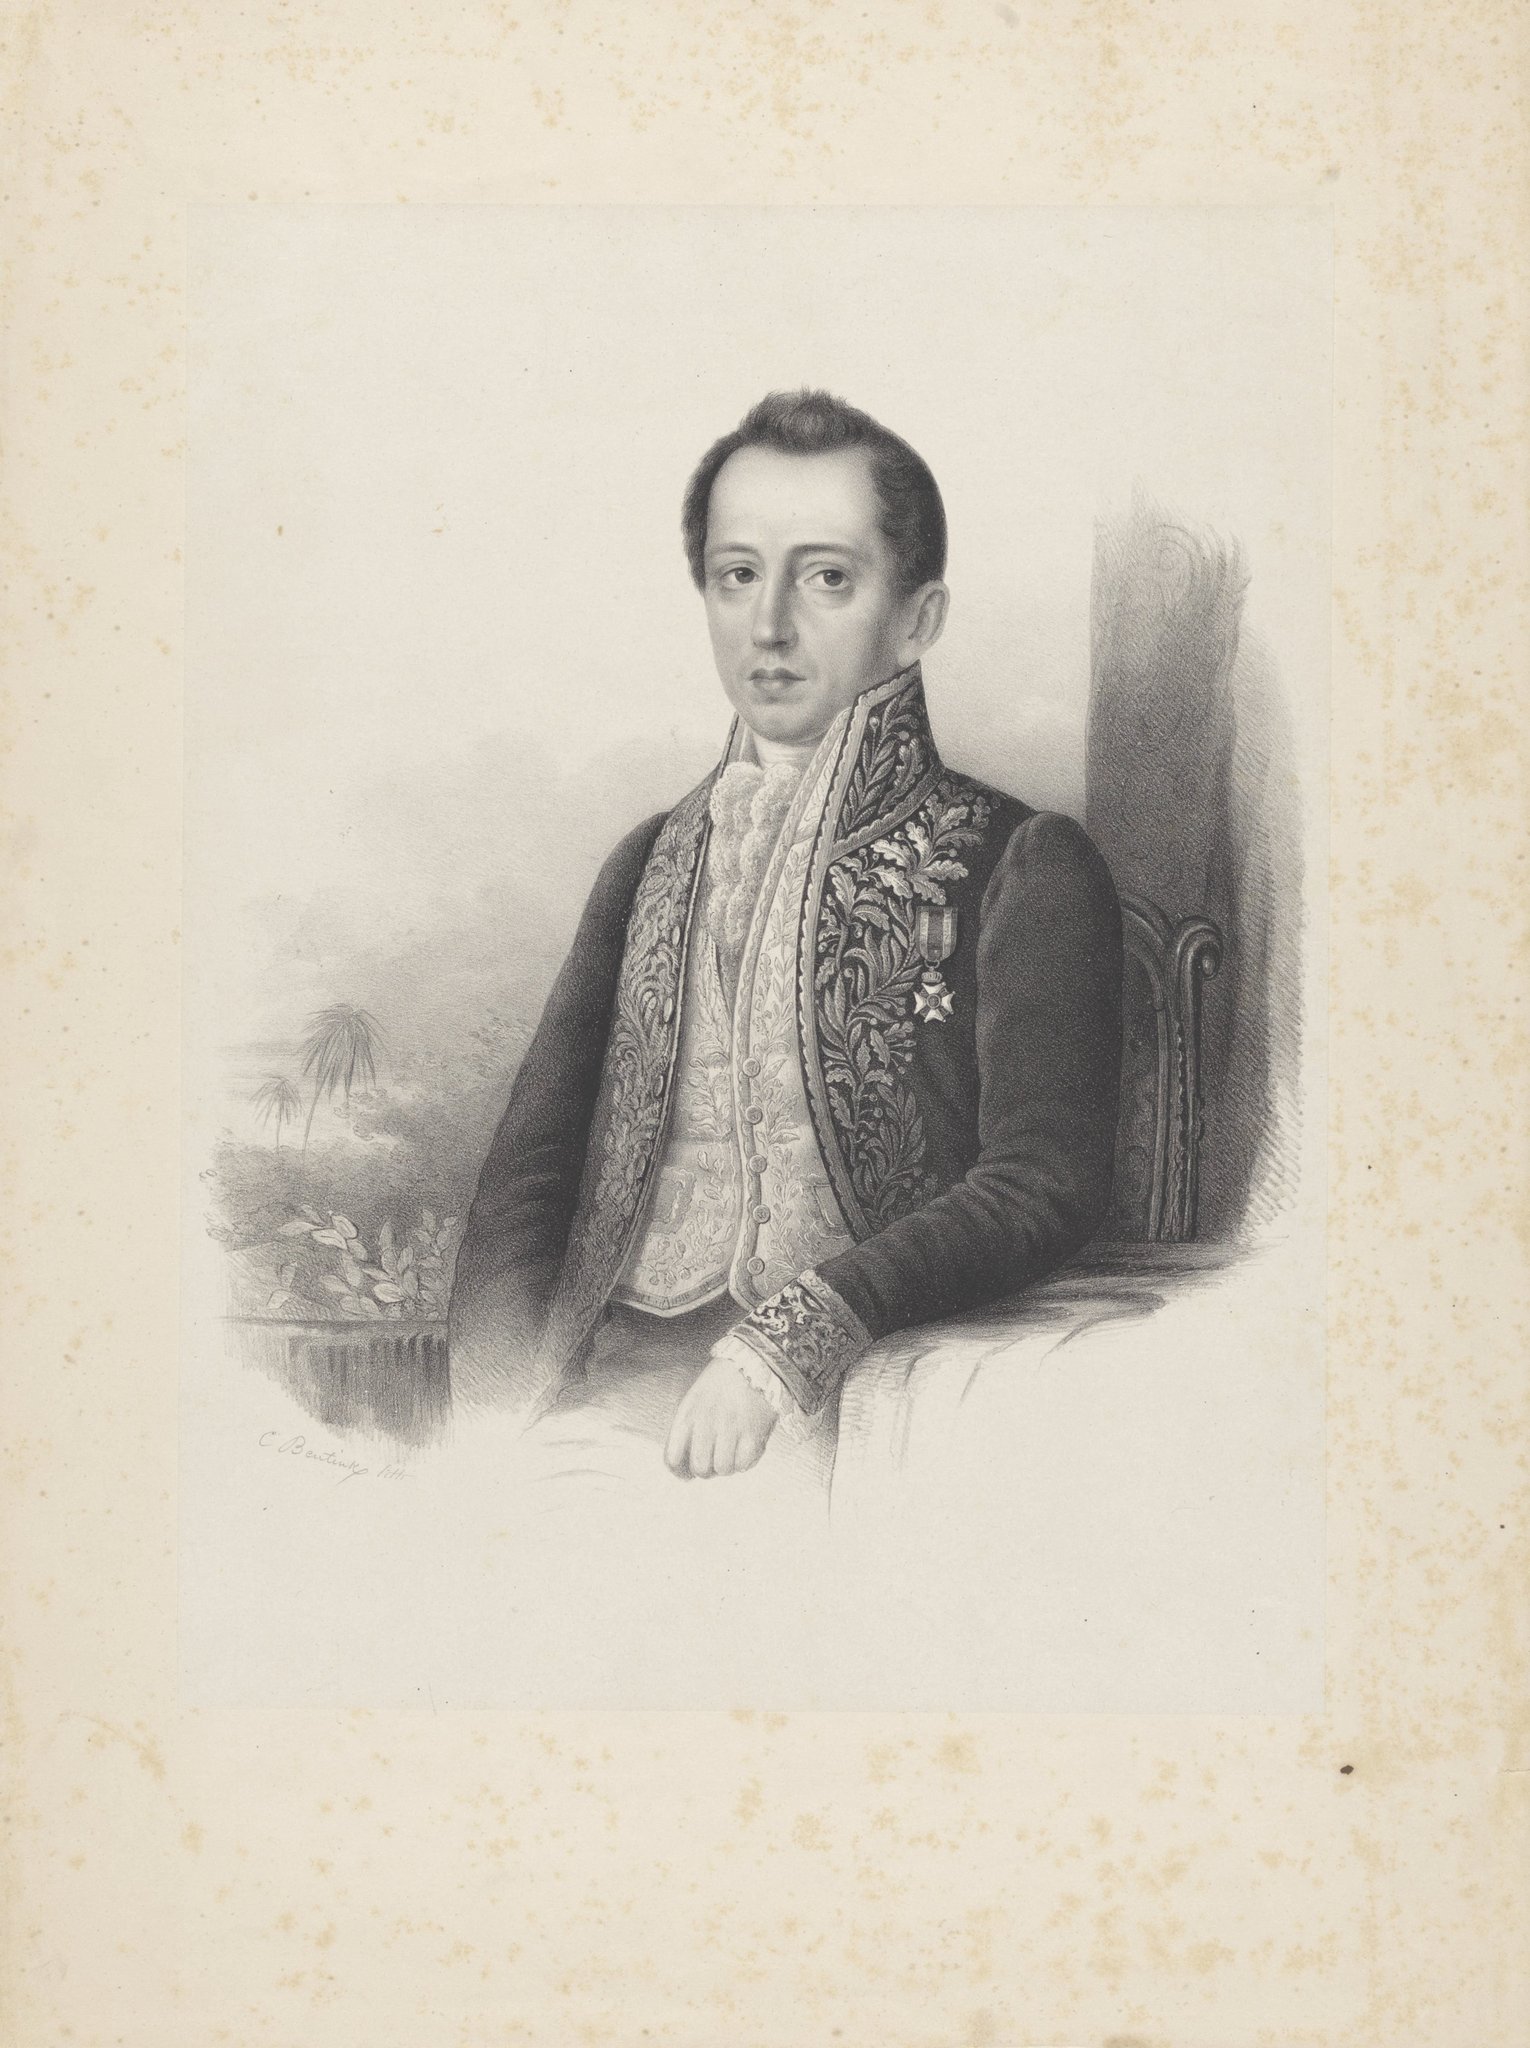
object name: print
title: Portret van een onbekende man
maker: carel frederik curtenius bentinck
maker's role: print maker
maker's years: 1814-1849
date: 1824-1849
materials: paper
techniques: lithograph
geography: netherlands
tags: knighthood order, historical persons, landscapes in tropical and sub-tropical regions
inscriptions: collector's mark: Lugt 2228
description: De geportretteerde draagt een jasje en gilet versierd met bladmotieven. Op zijn borst draagt hij een ridderode. Achter hem een tropisch landschap.